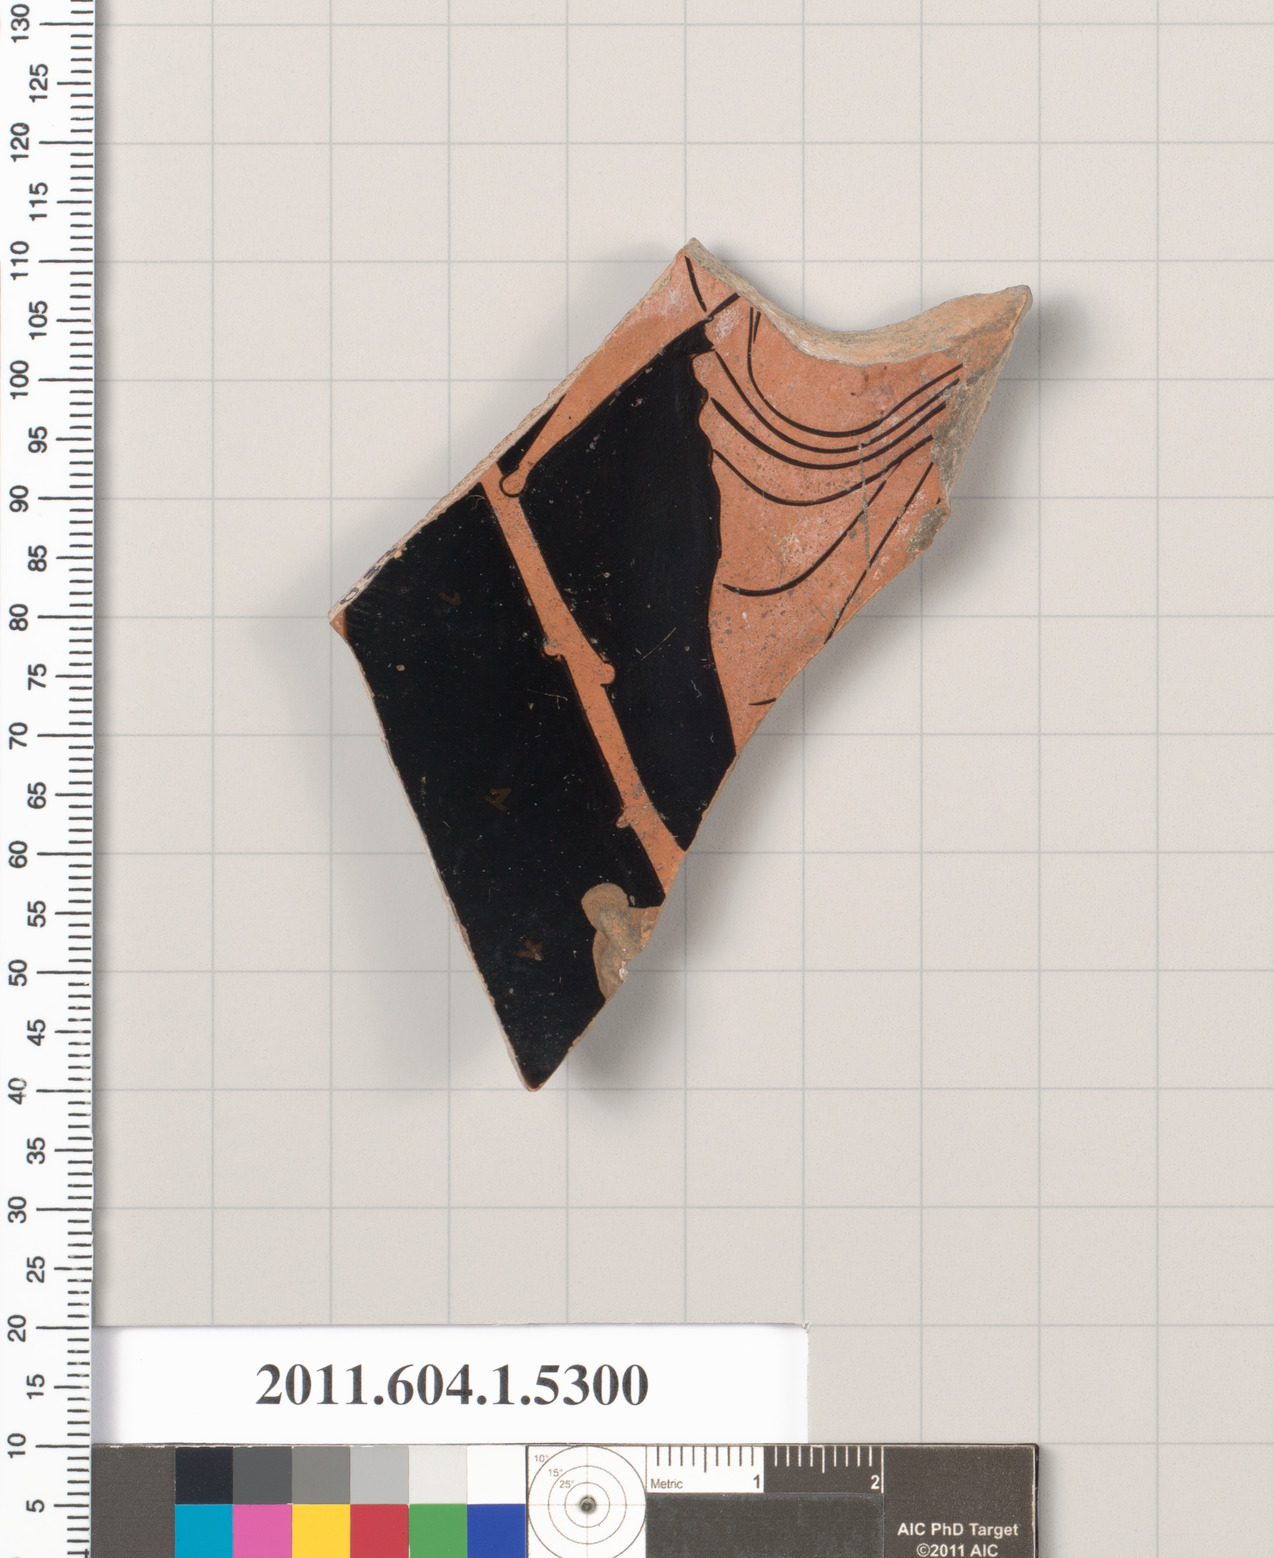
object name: kylix fragment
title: Terracotta fragment of a kylix (drinking cup)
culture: greek, attic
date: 500-480 BCE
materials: terracotta